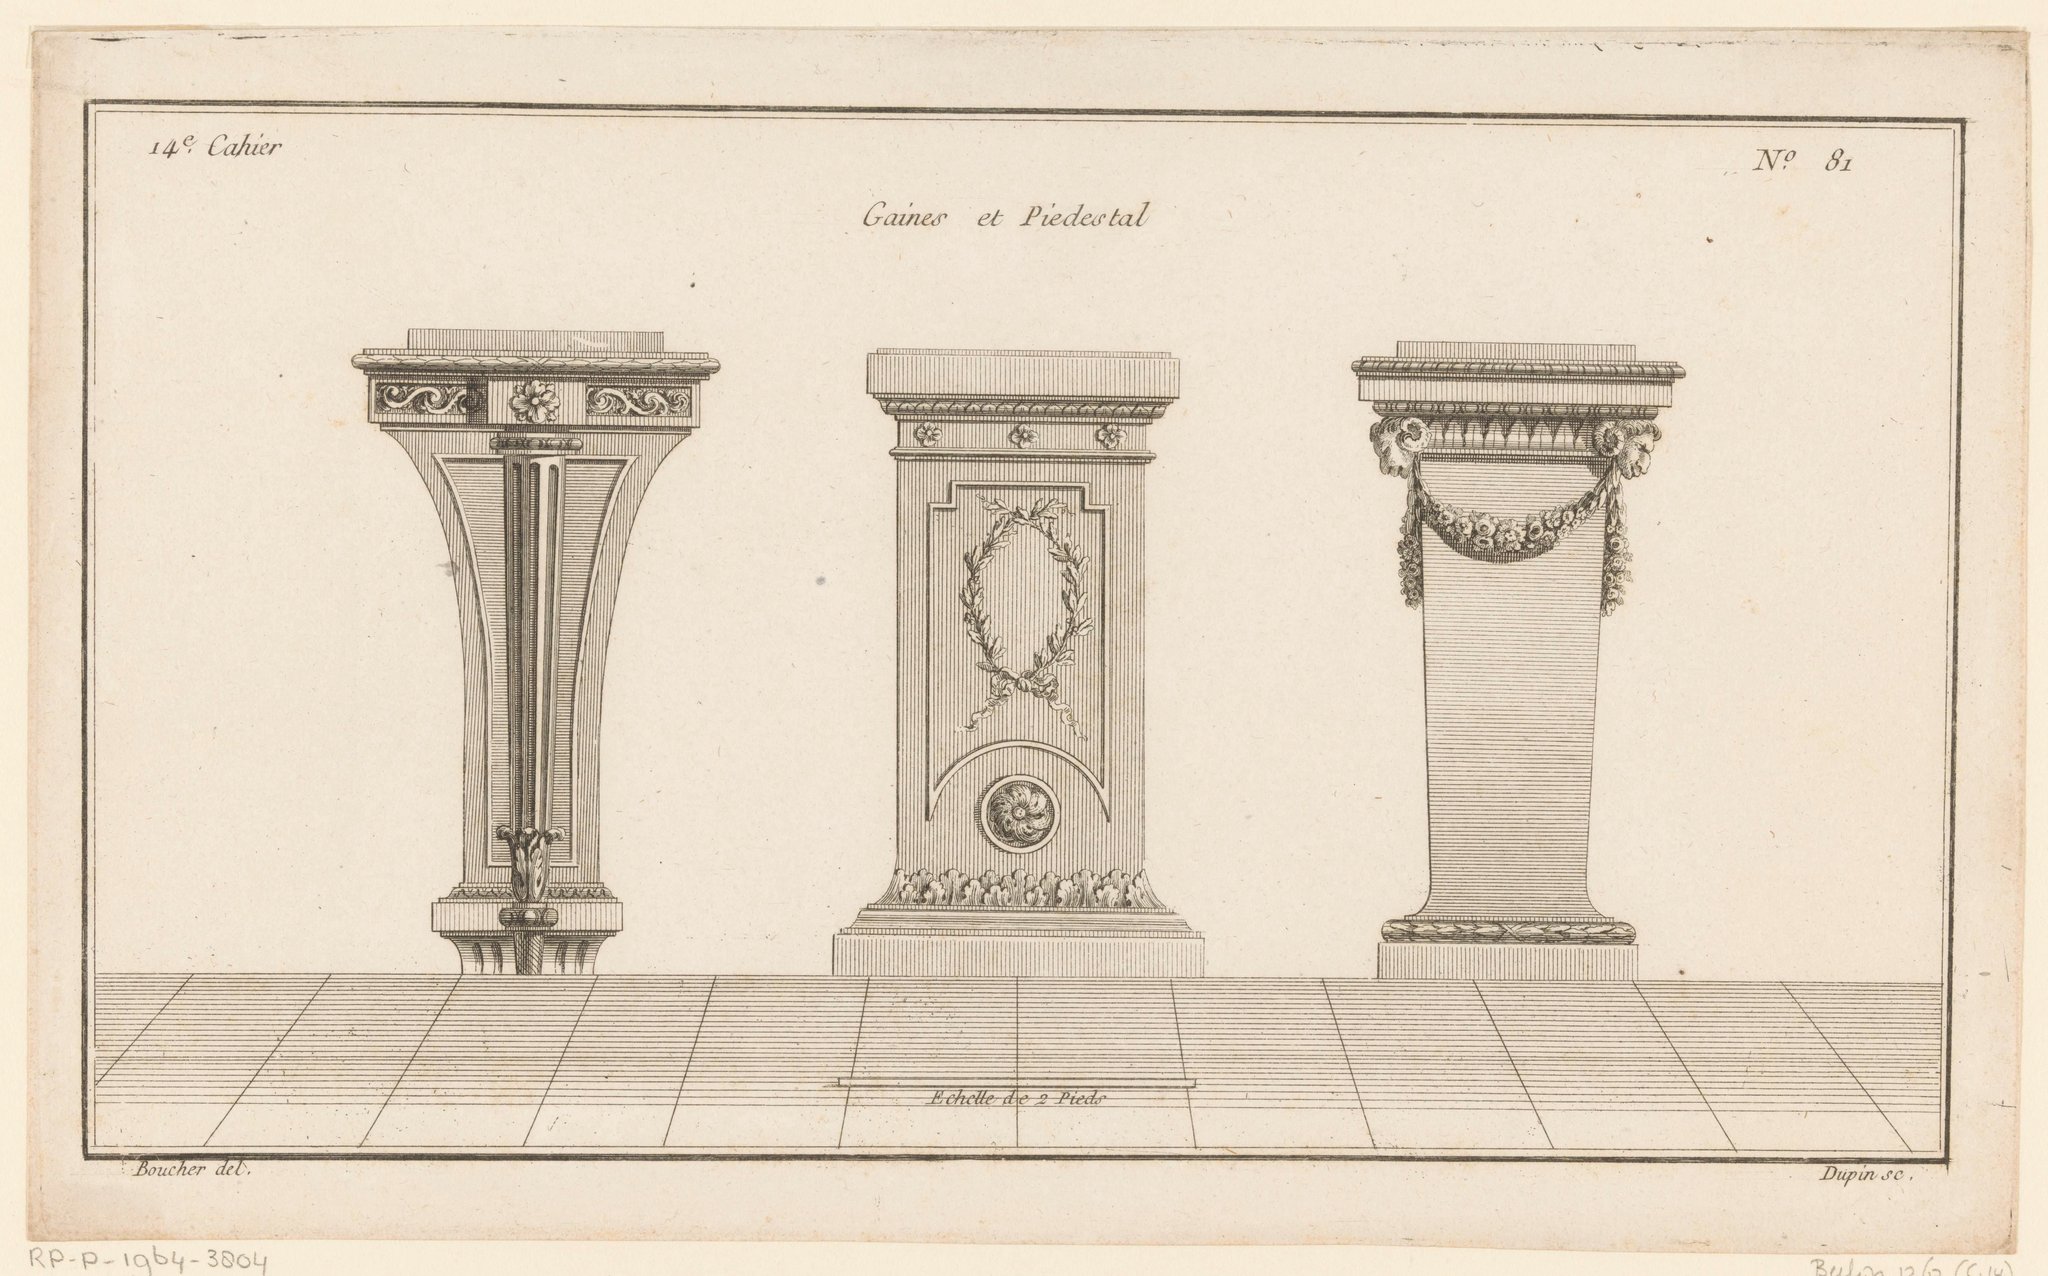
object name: print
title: 14e Cahier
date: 1772-1779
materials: paper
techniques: engraving, etching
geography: paris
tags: ram's head ~ ornament, pedestal of a piece of sculpture (perhaps in the form of a herm), ornament ~ festoon, garland, ornament derived from plant forms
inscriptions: collector's mark: Lugt 2760, collector's mark: Lugt 2228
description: Drie geornamenteerde voetstukken met blad- en bloemmotieven, rechts met ramskoppen en guirlande. Prentnummer 81.